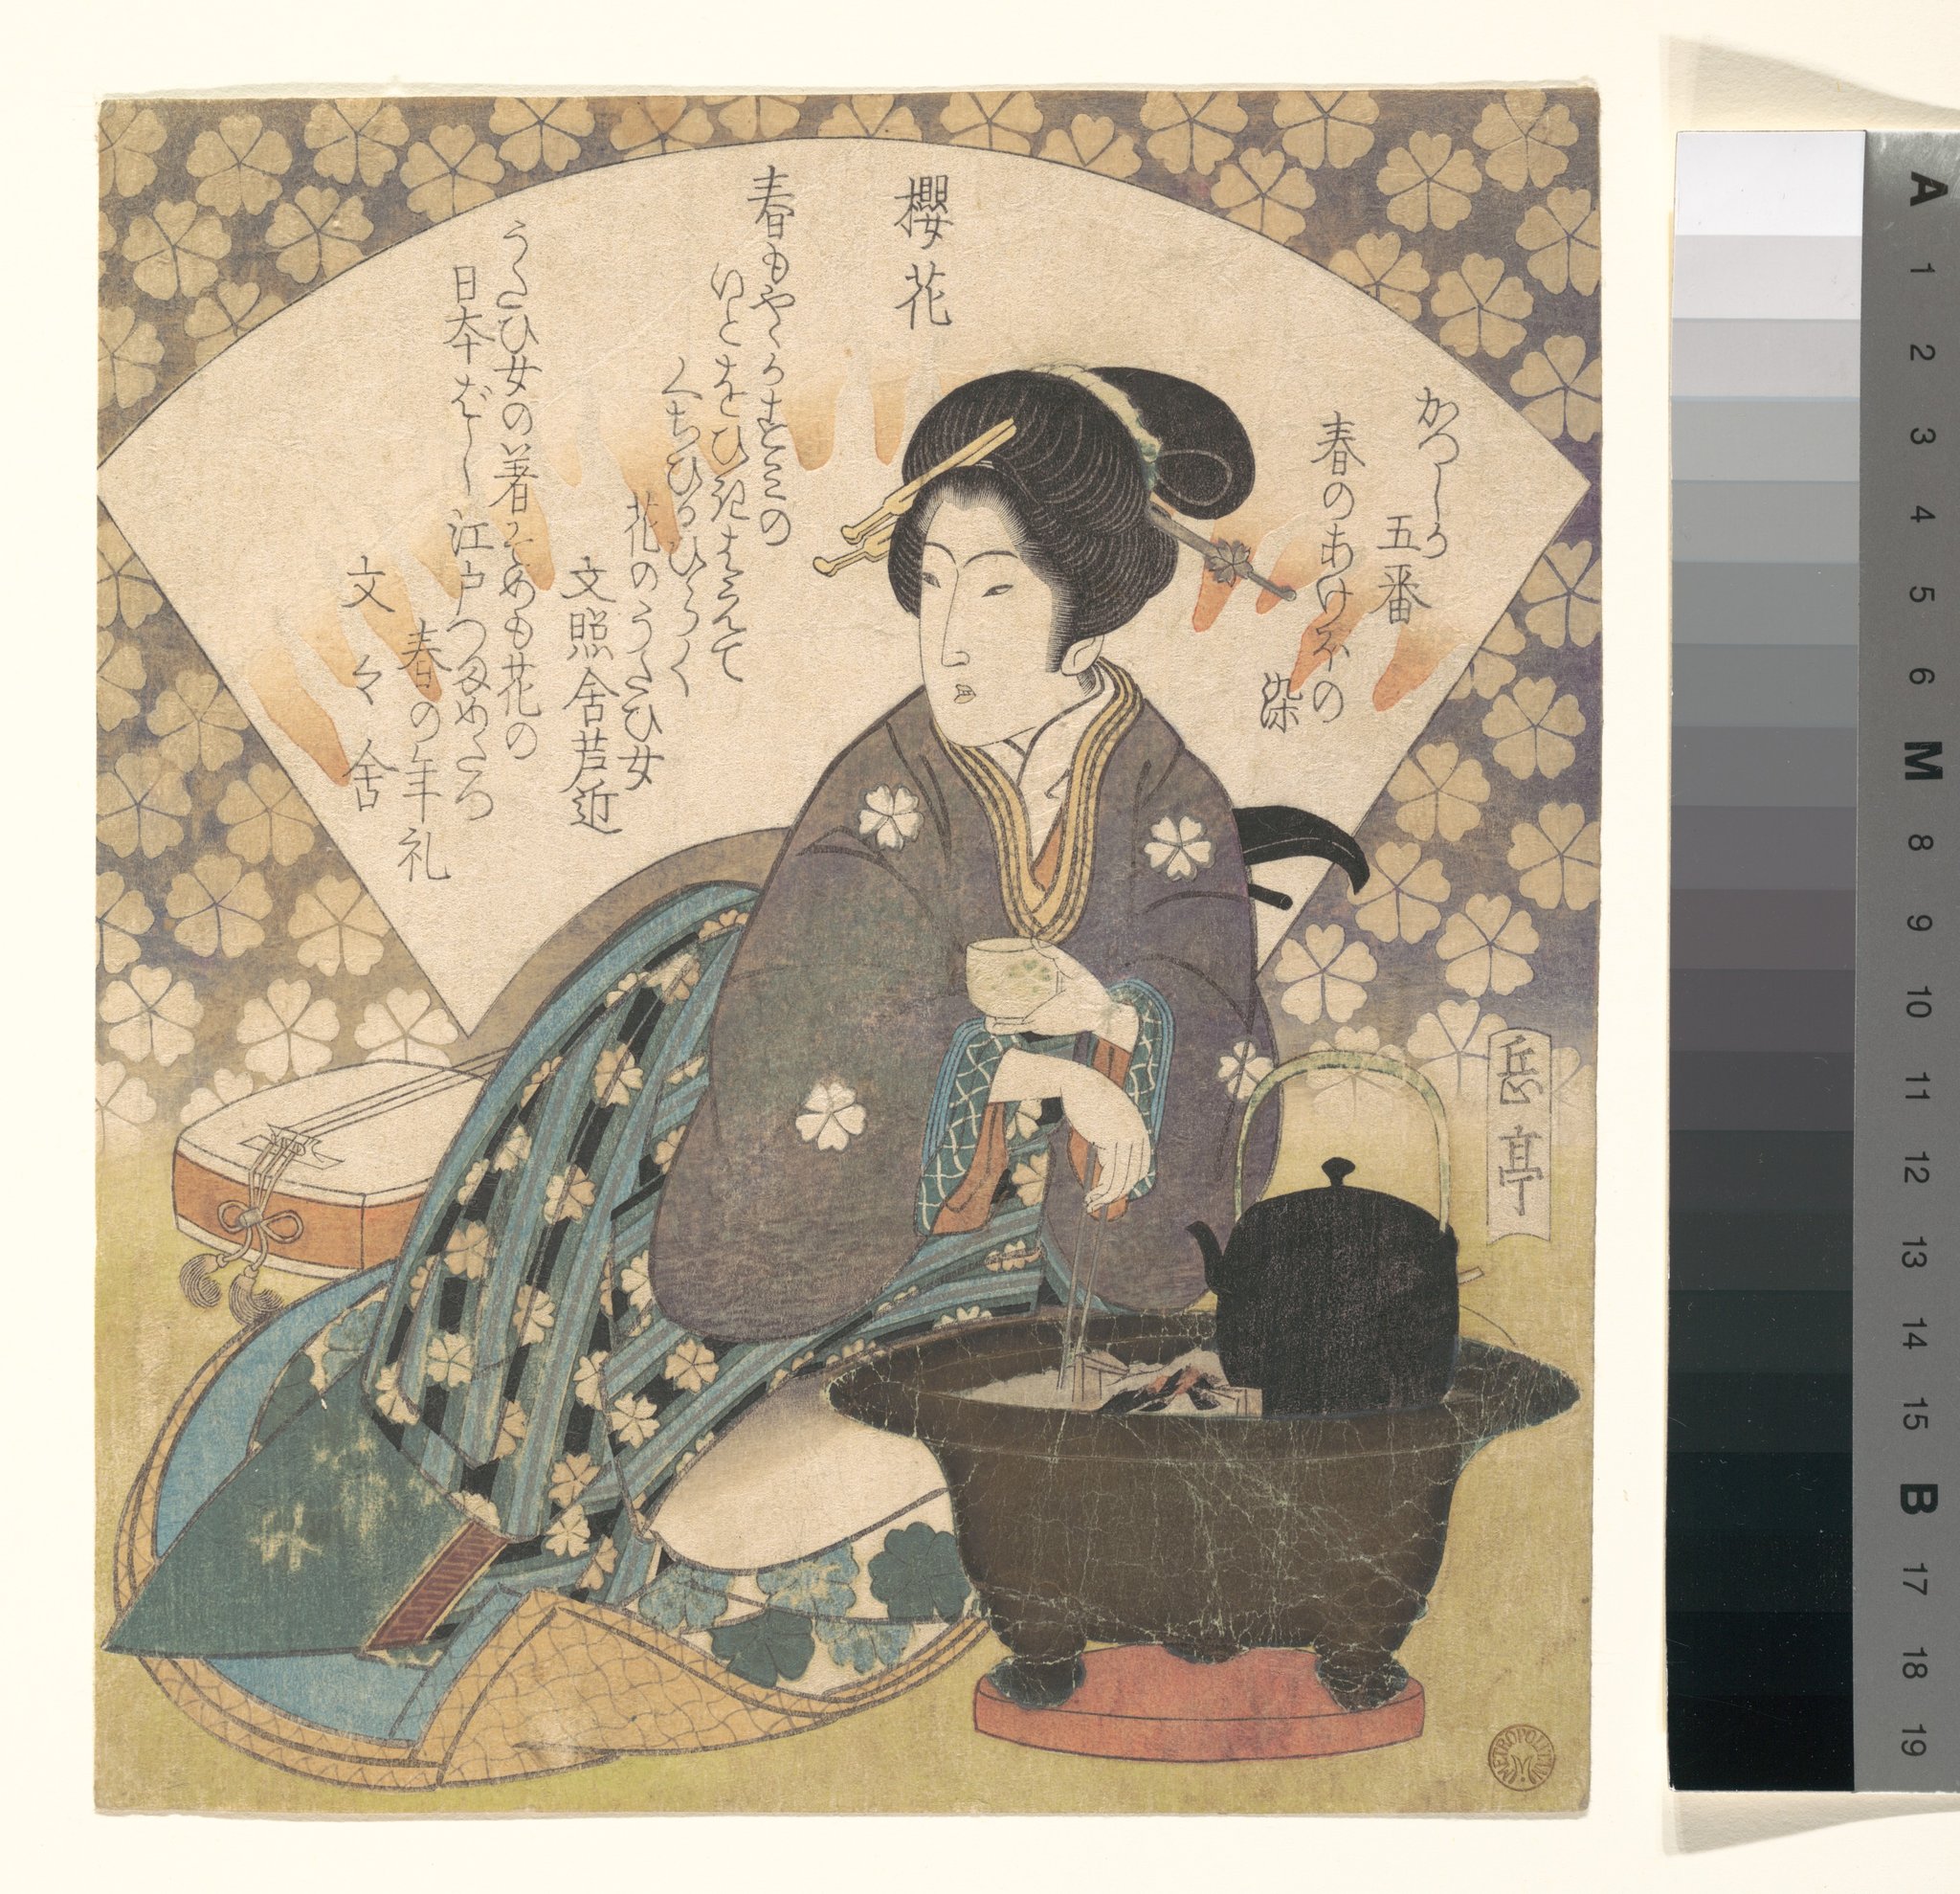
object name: print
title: Courtesan Drinking Tea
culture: japanese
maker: yashima gakutei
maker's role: artist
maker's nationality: japanese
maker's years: 1786-1868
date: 1830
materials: ink, paper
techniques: surimono, woodblock print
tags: women,tea drinking,teapots